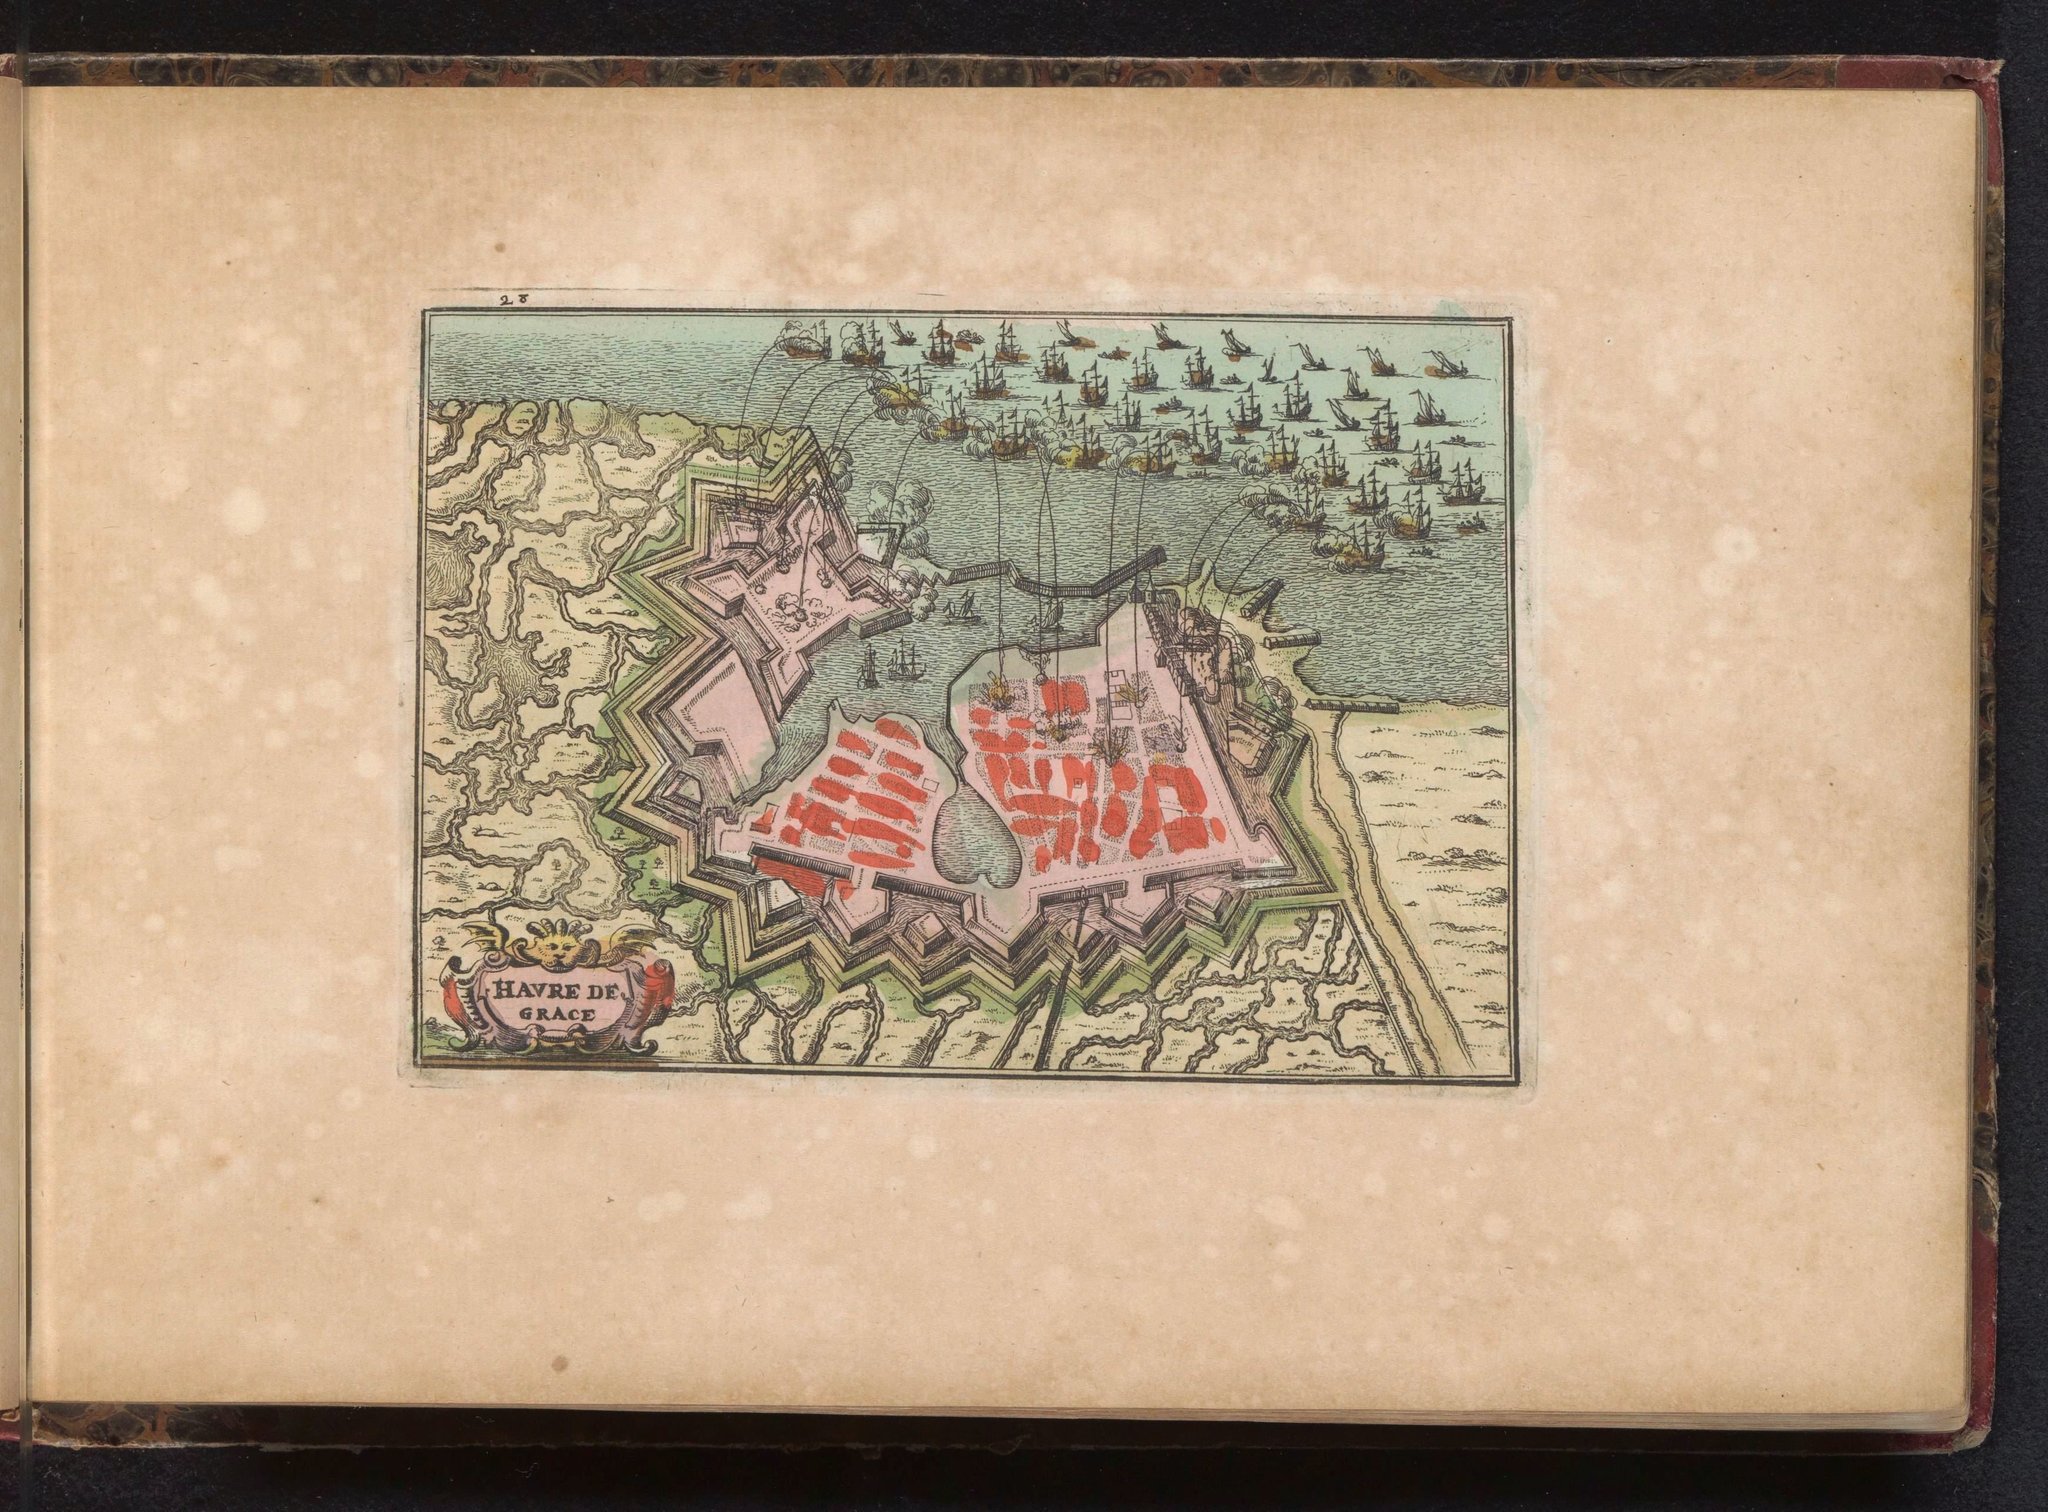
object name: map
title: Havre de Grace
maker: Anonymous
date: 1700-1702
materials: paper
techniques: engraving, etching, hand coloring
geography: northern netherlands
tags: maps of cities, bombardment, le havre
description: Bombardement van de Franse havenplaats Le Havre, waarschijnlijk door de gecombineerde Engelse en Hollandse vloot, juli 1694. Onderdeel van een atlas met 223 kaarten van landen en steden en oorlogstaferelen in Europa in de periode ca. 1690-1735.